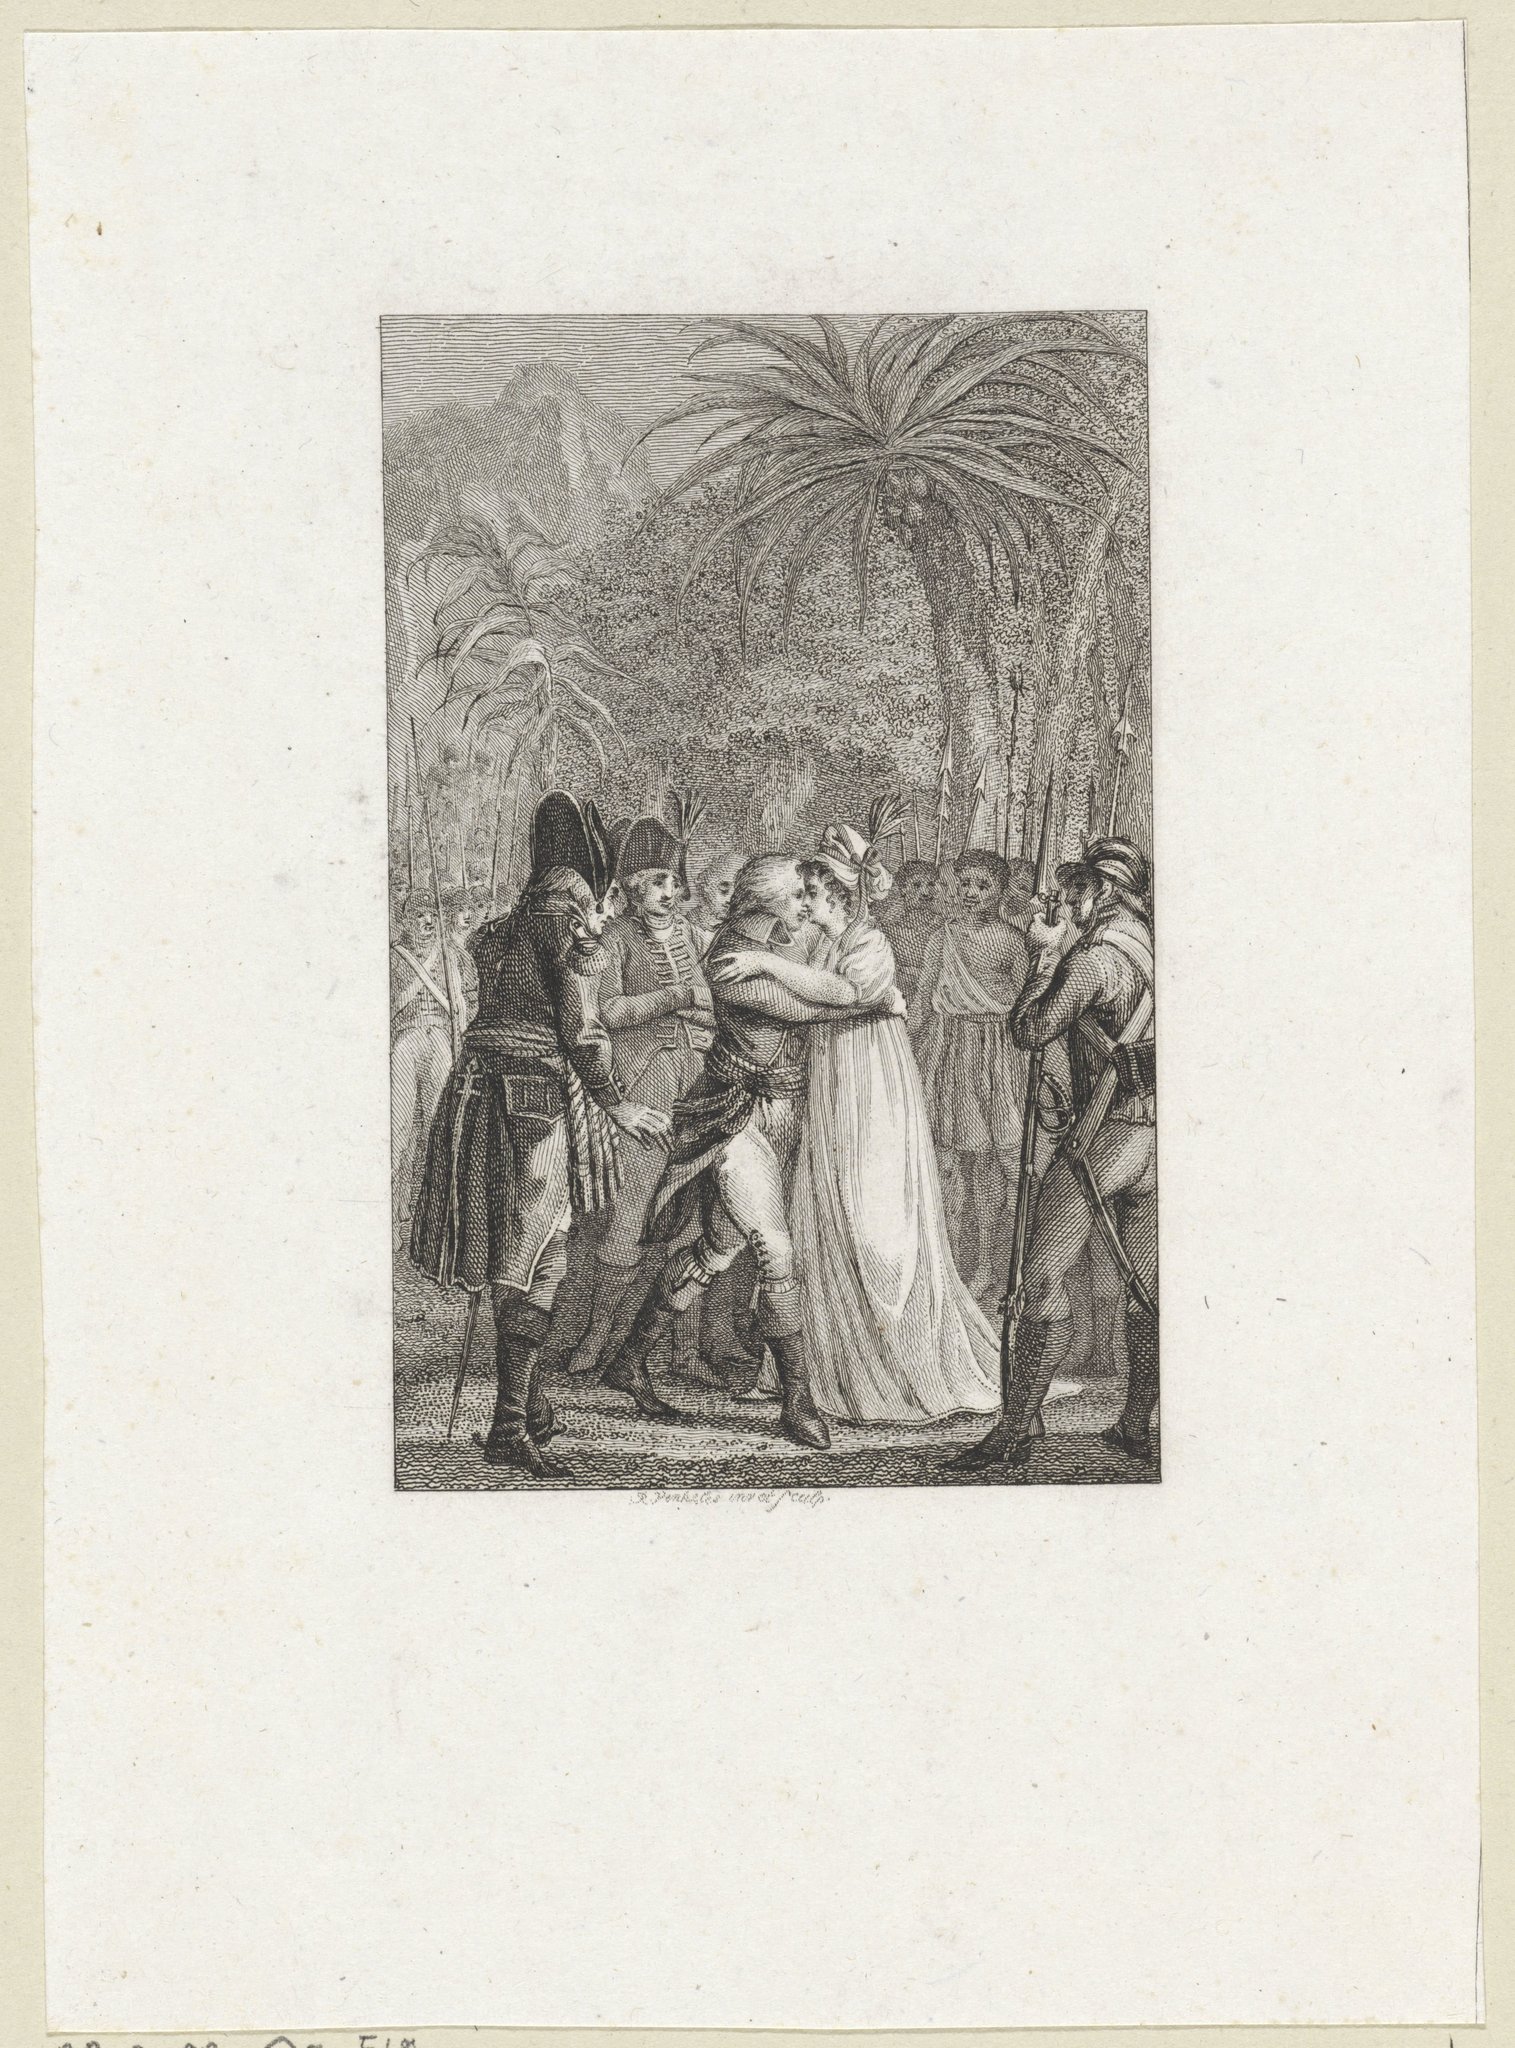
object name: print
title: Omringd door soldaten en Afrikanen omhelzen een man en vrouw elkaar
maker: reinier vinkeles (i)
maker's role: draughtsman, print maker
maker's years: 1741-1816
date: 1751-1816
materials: paper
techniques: engraving, etching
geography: amsterdam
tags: africans, embracing each other, kissing, the soldier; the soldier's life, trees: palm-tree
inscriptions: collector's mark: Lugt 240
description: Proefdruk van een prent die mogelijk ook gebruikt is als illustratie in: Brandes, J.C. De Schipbreuk.